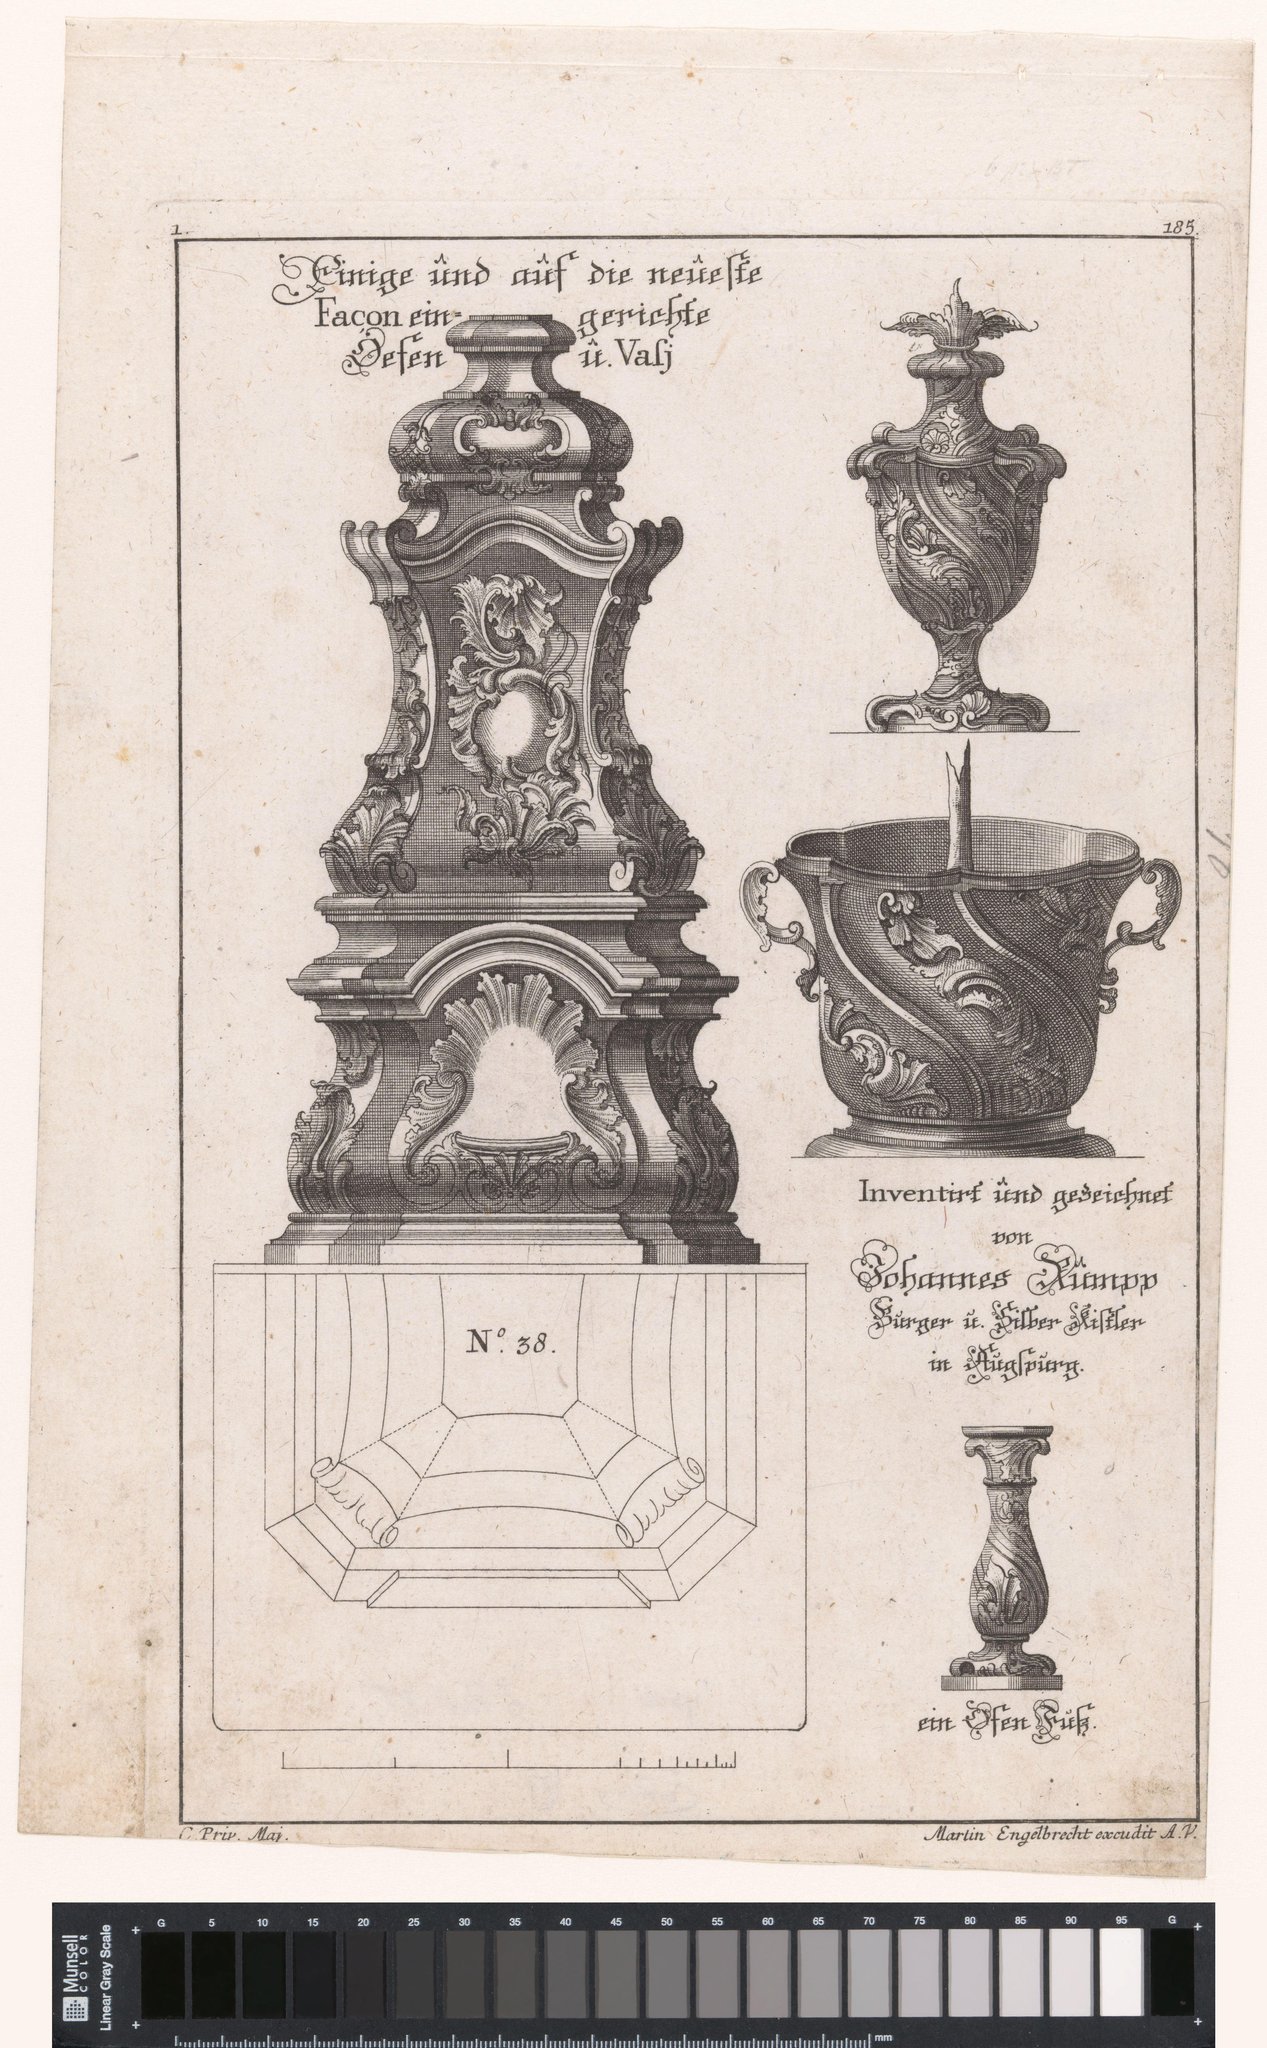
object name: print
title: Einige und auf die neueste Façon eingerichte Oefen u. Vasi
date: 1712-1755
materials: paper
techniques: engraving, etching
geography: augsburg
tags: pedestal of a piece of sculpture (perhaps in the form of a herm), container of ceramics: jar, jug, pot, vase, heating stove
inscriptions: collector's mark: Lugt 2228, collector's mark: Lugt 2760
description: Ontwerpen voor een geornamenteerde kachel, een vaas, een pot en een voetstuk. Van de kachel ook een plattegrond. Prentnummer 185, uitgeversnummer 38.